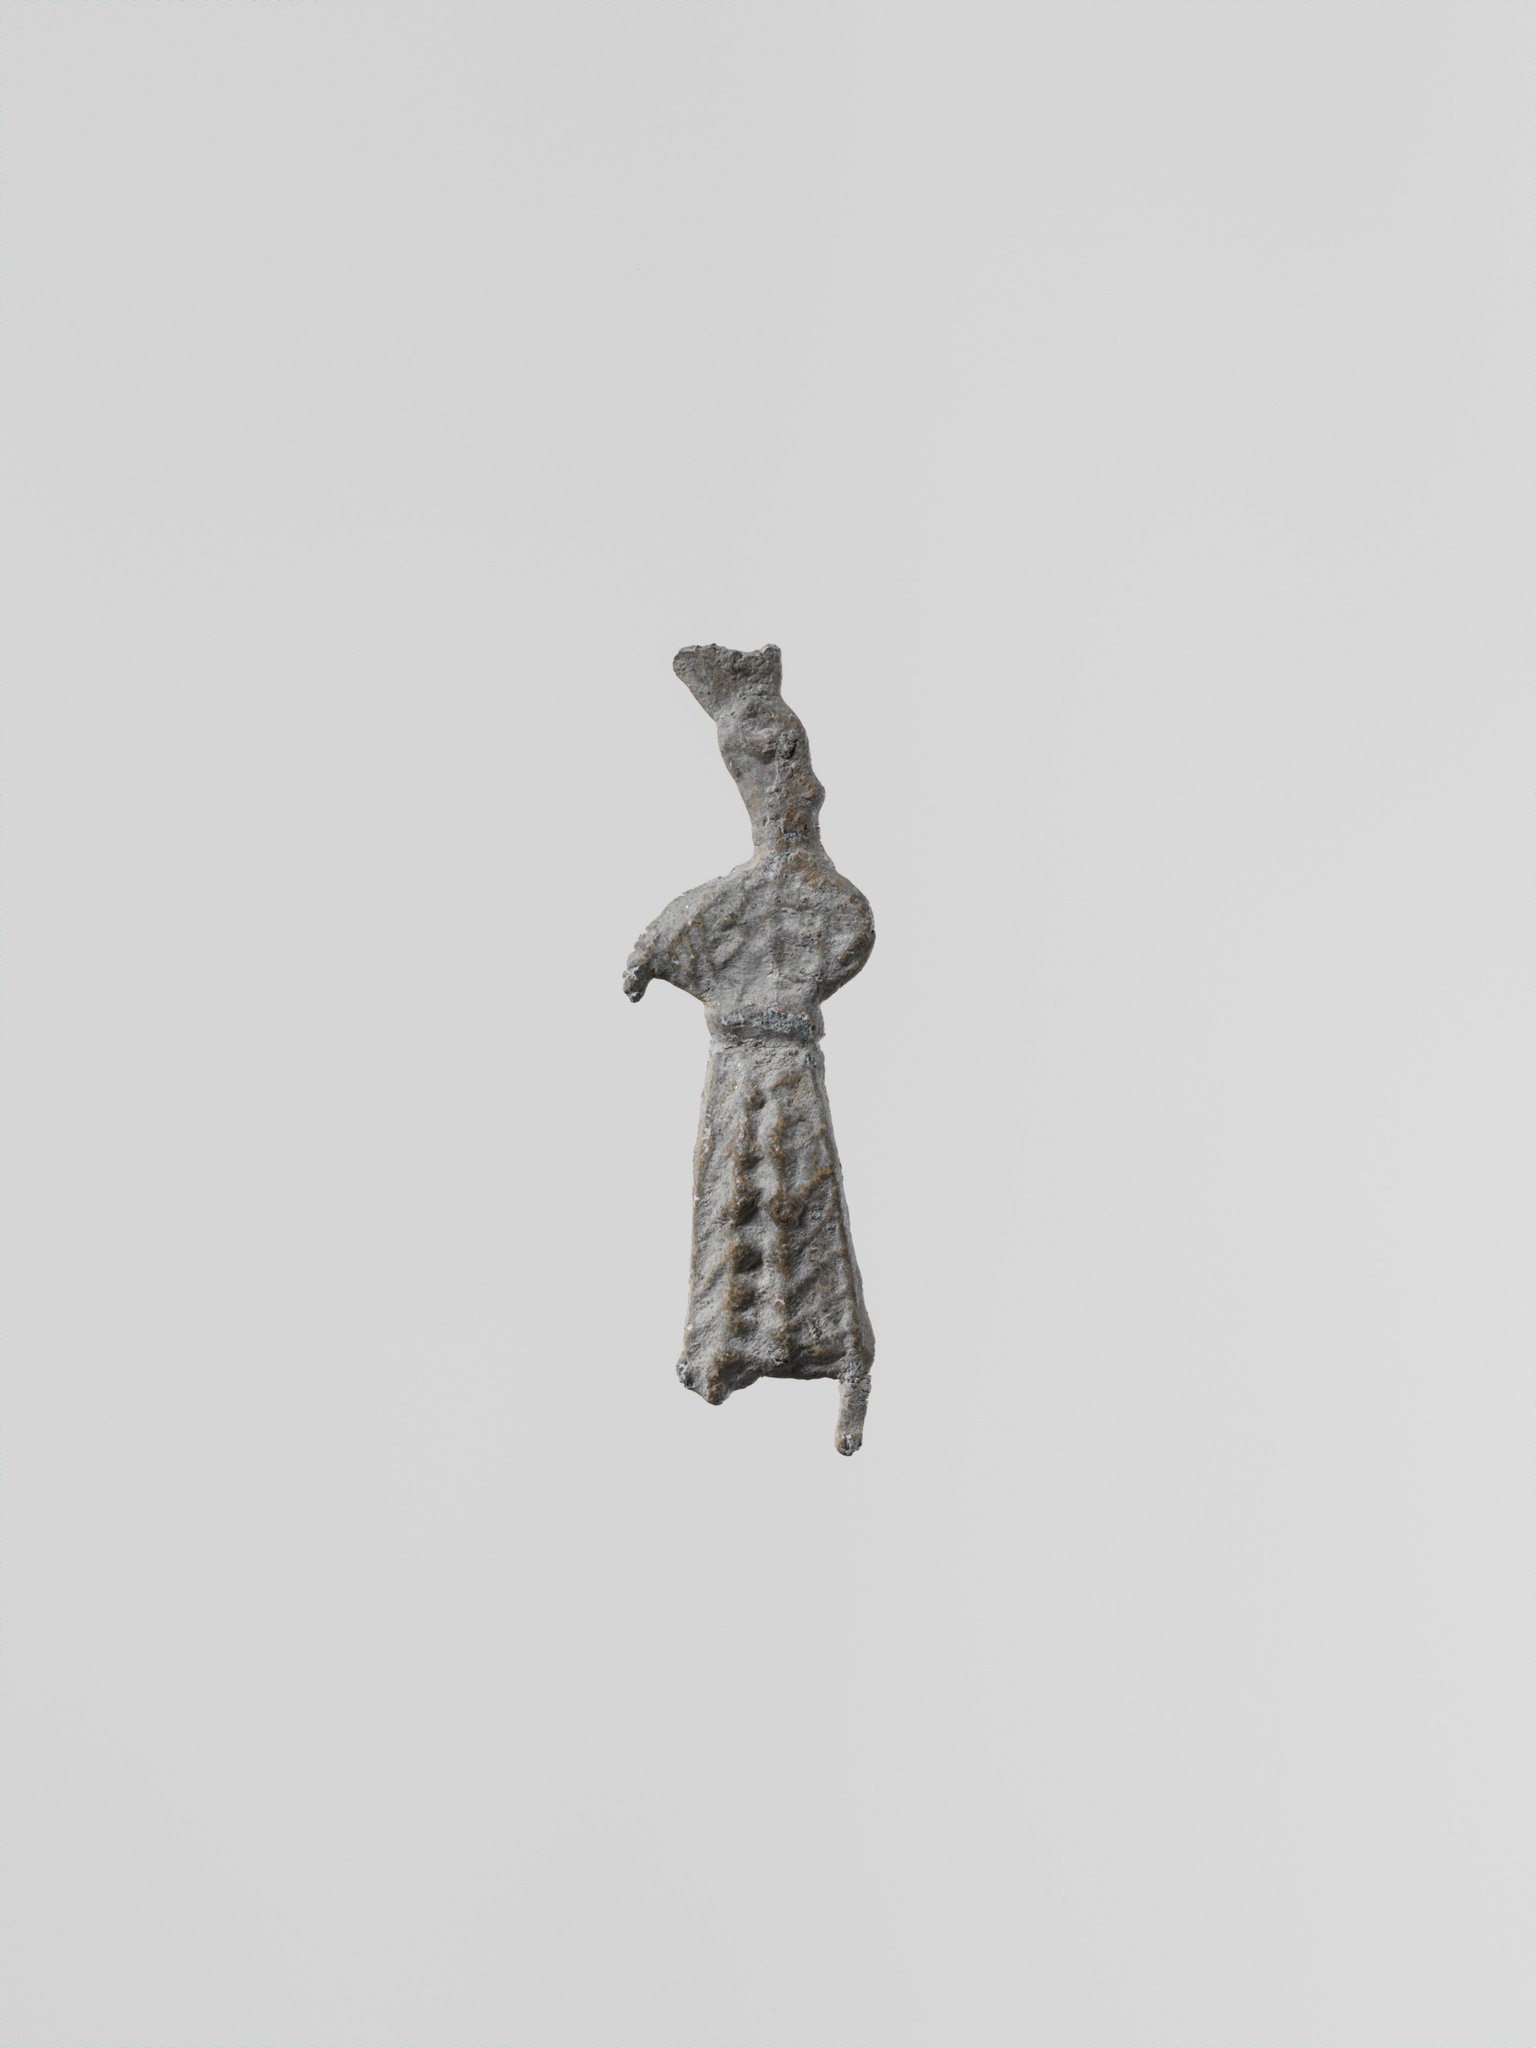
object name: statuette of a woman votary, 5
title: Statuette of a woman votary, 5 ?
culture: greek, laconian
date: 700-500 BCE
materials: lead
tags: women